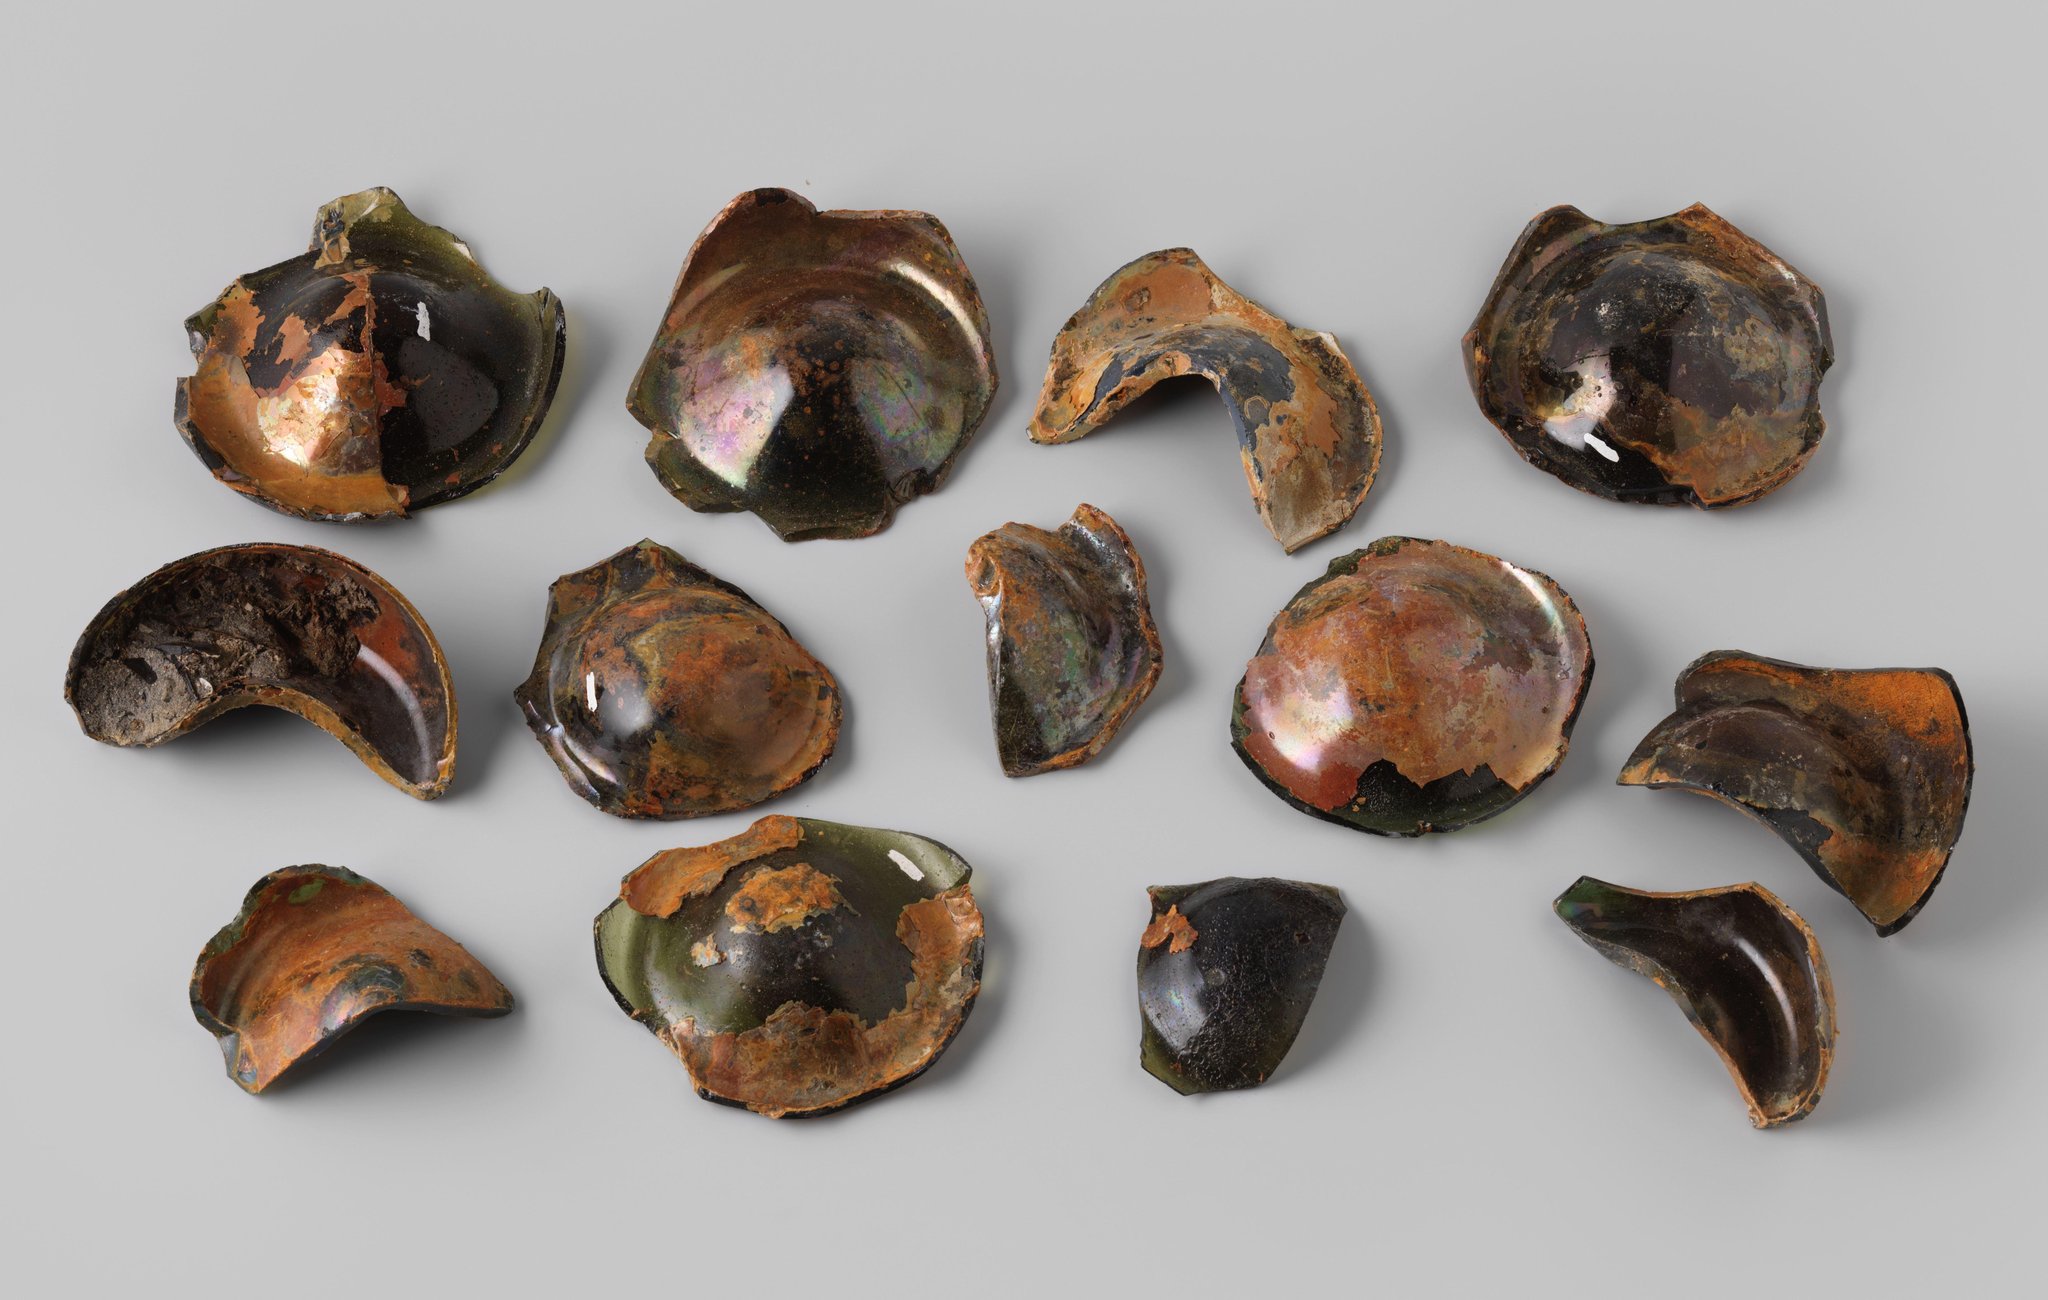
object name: wine bottle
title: Scherven van wijnflessen uit het wrak van de Oost-Indiëvaarder 't Vliegend Hart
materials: glass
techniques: green glass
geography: netherlands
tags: 't vliegend hart (schip), verenigde oostindische compagnie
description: Scherven van uivormige wijnflessen van groen glas waar rode (port)wijn in heeft gezeten. Bodemfragmenten.